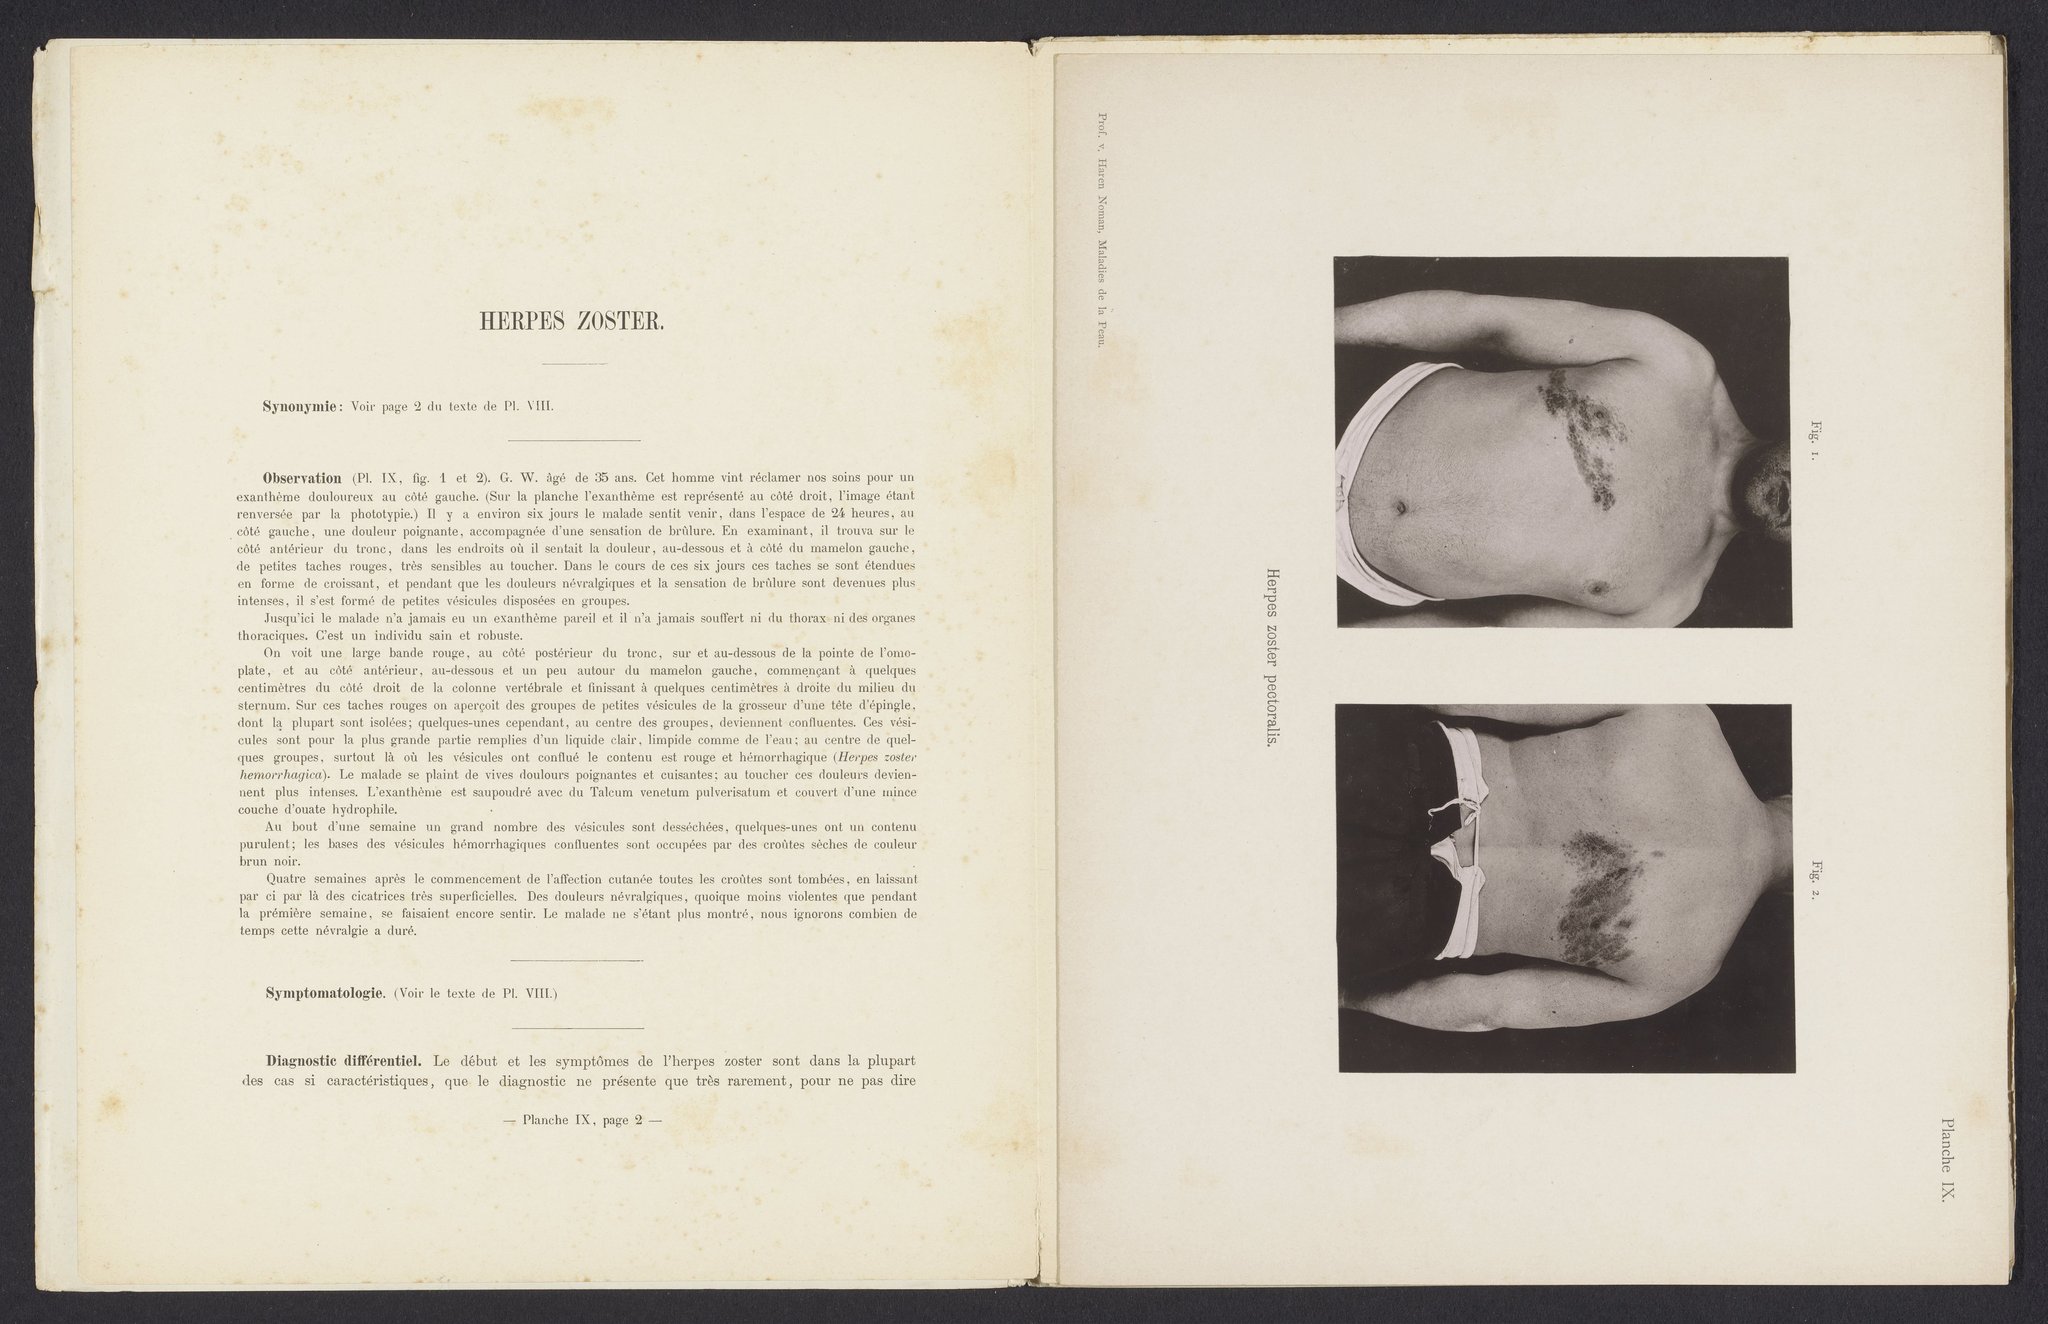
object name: photomechanical print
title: Herpes zoster pectoralis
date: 1880-1889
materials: paper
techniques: photograph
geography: haarlem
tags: chest, bust, adult woman, skin and venereal diseases, back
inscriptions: number: ‘Planche IX / Fig. 1. / Fig. 2.’